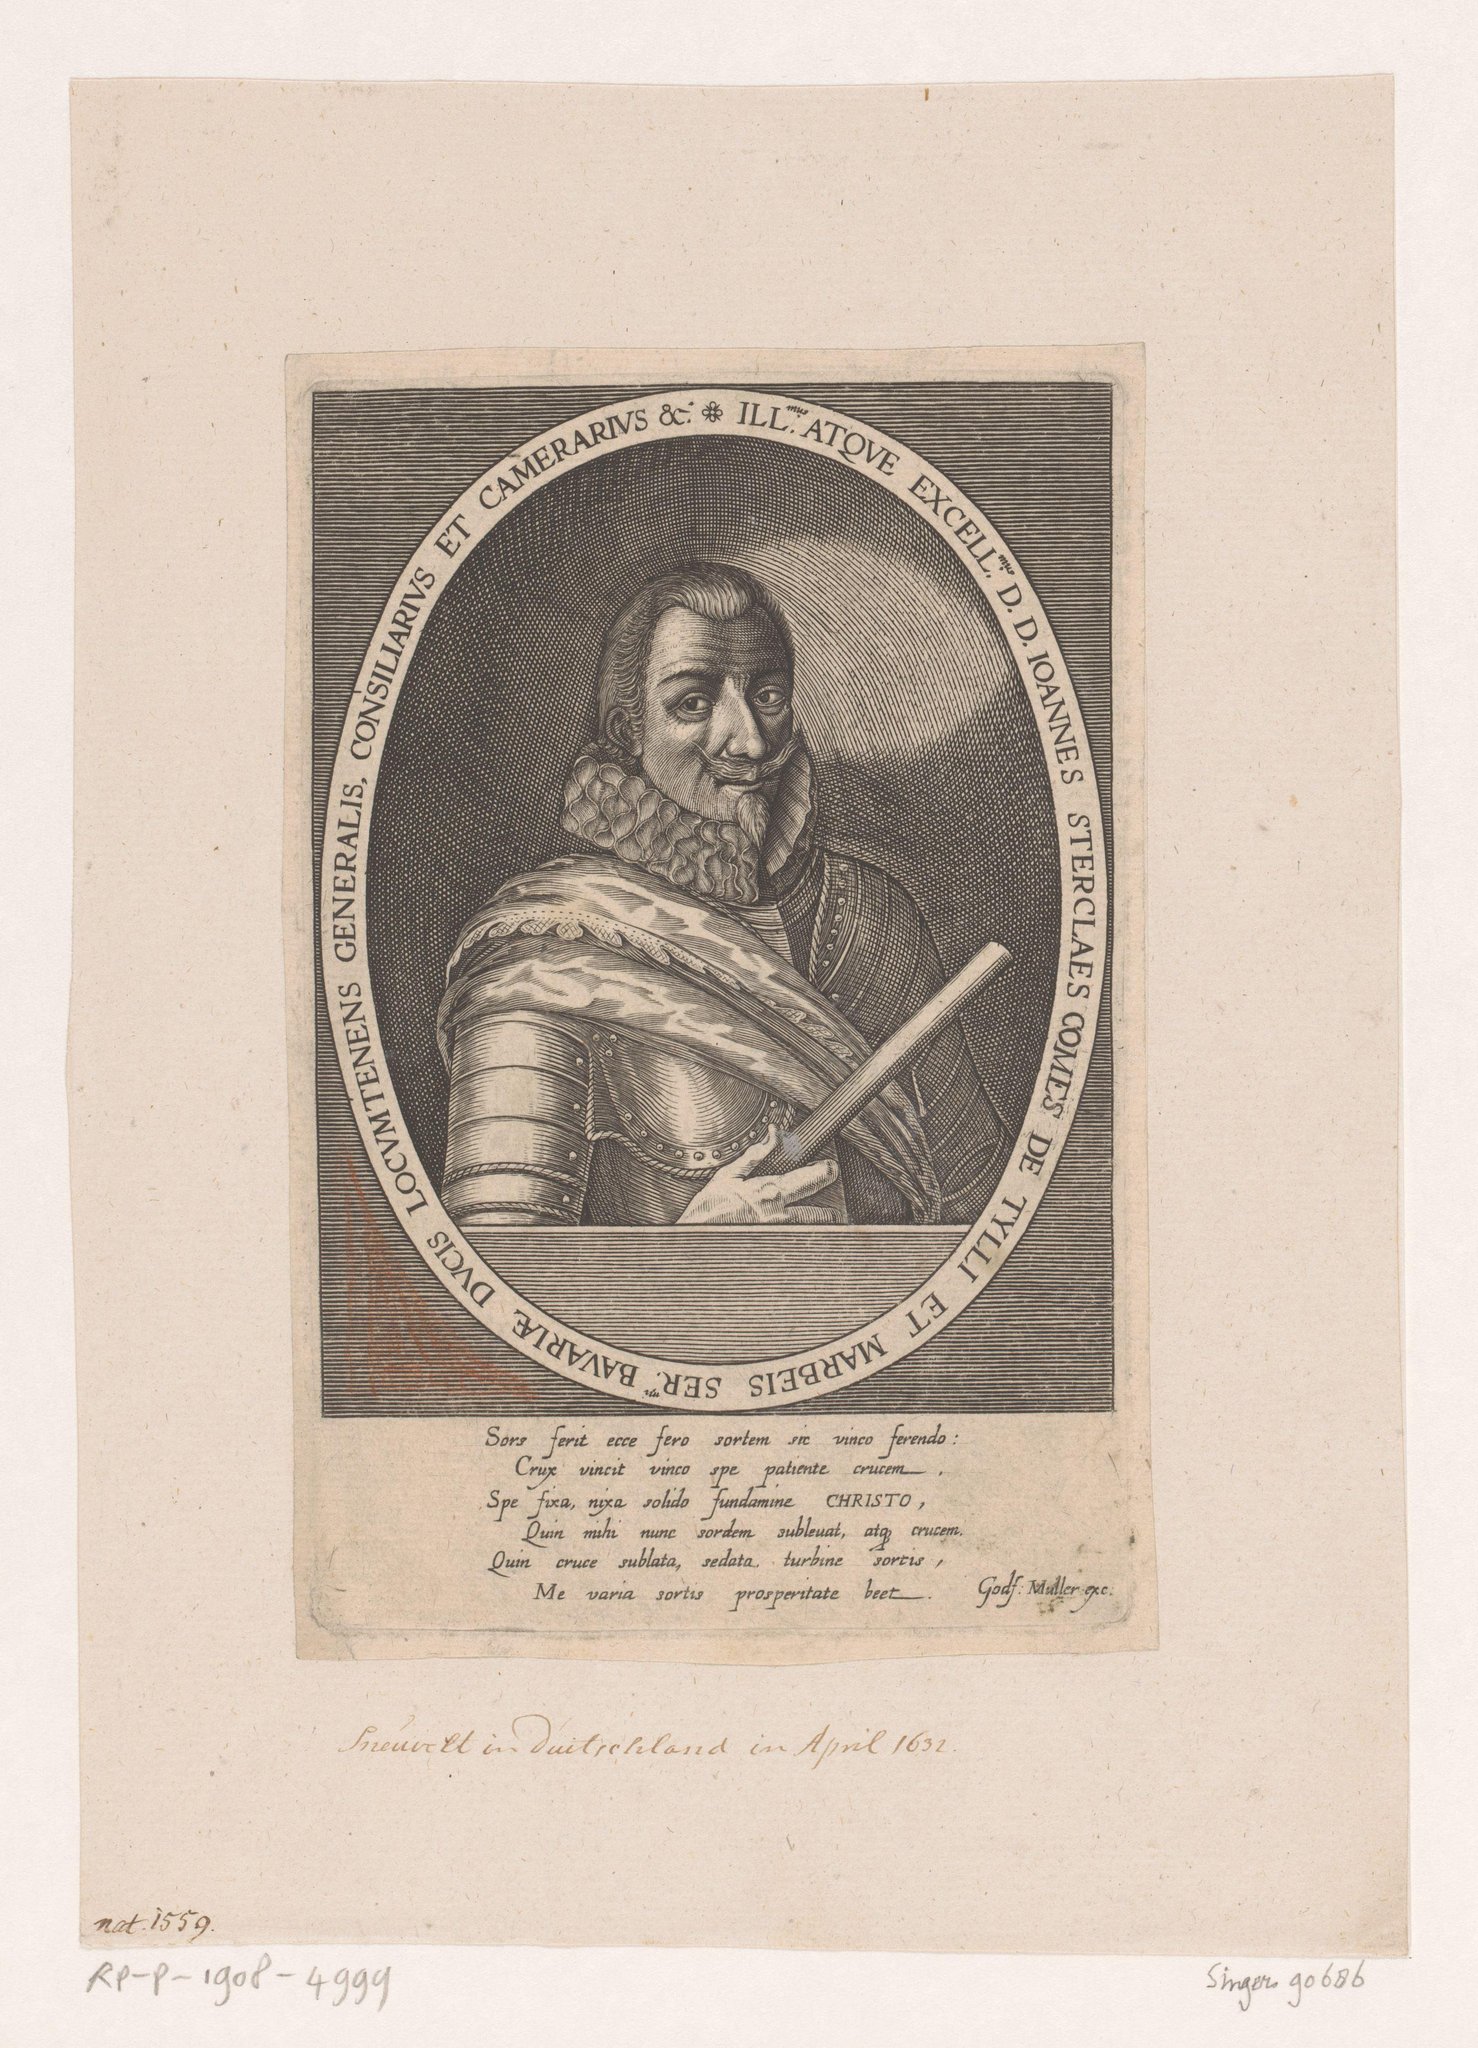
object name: print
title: Portret van Johan 't Serclaes, graaf van Tilly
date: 1620-1656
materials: paper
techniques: engraving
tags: armour, historical persons, baton of general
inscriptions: collector's mark: Lugt 2228